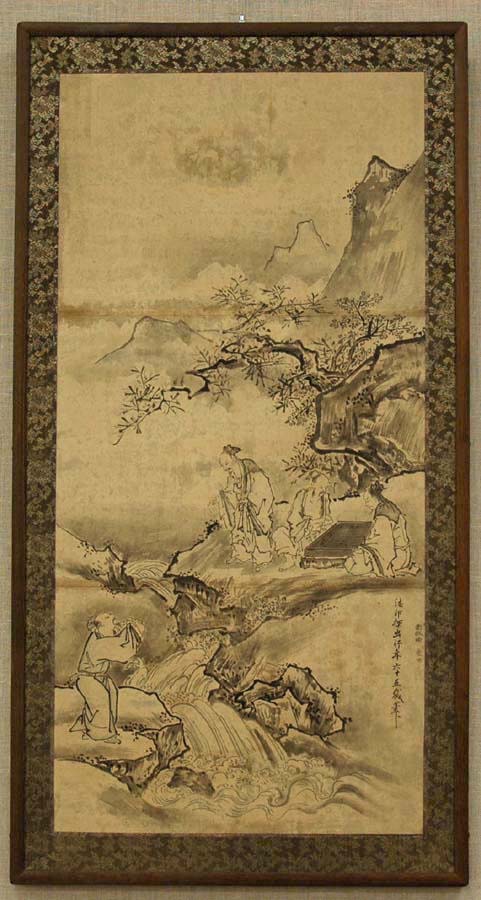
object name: hanging scroll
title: Sketch for a Painting of Scholars at the Game of Go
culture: japanese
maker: kano tan'yū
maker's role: artist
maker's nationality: japanese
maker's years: 1602-1674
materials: ink, panel, paper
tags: men,mountains,landscapes,games